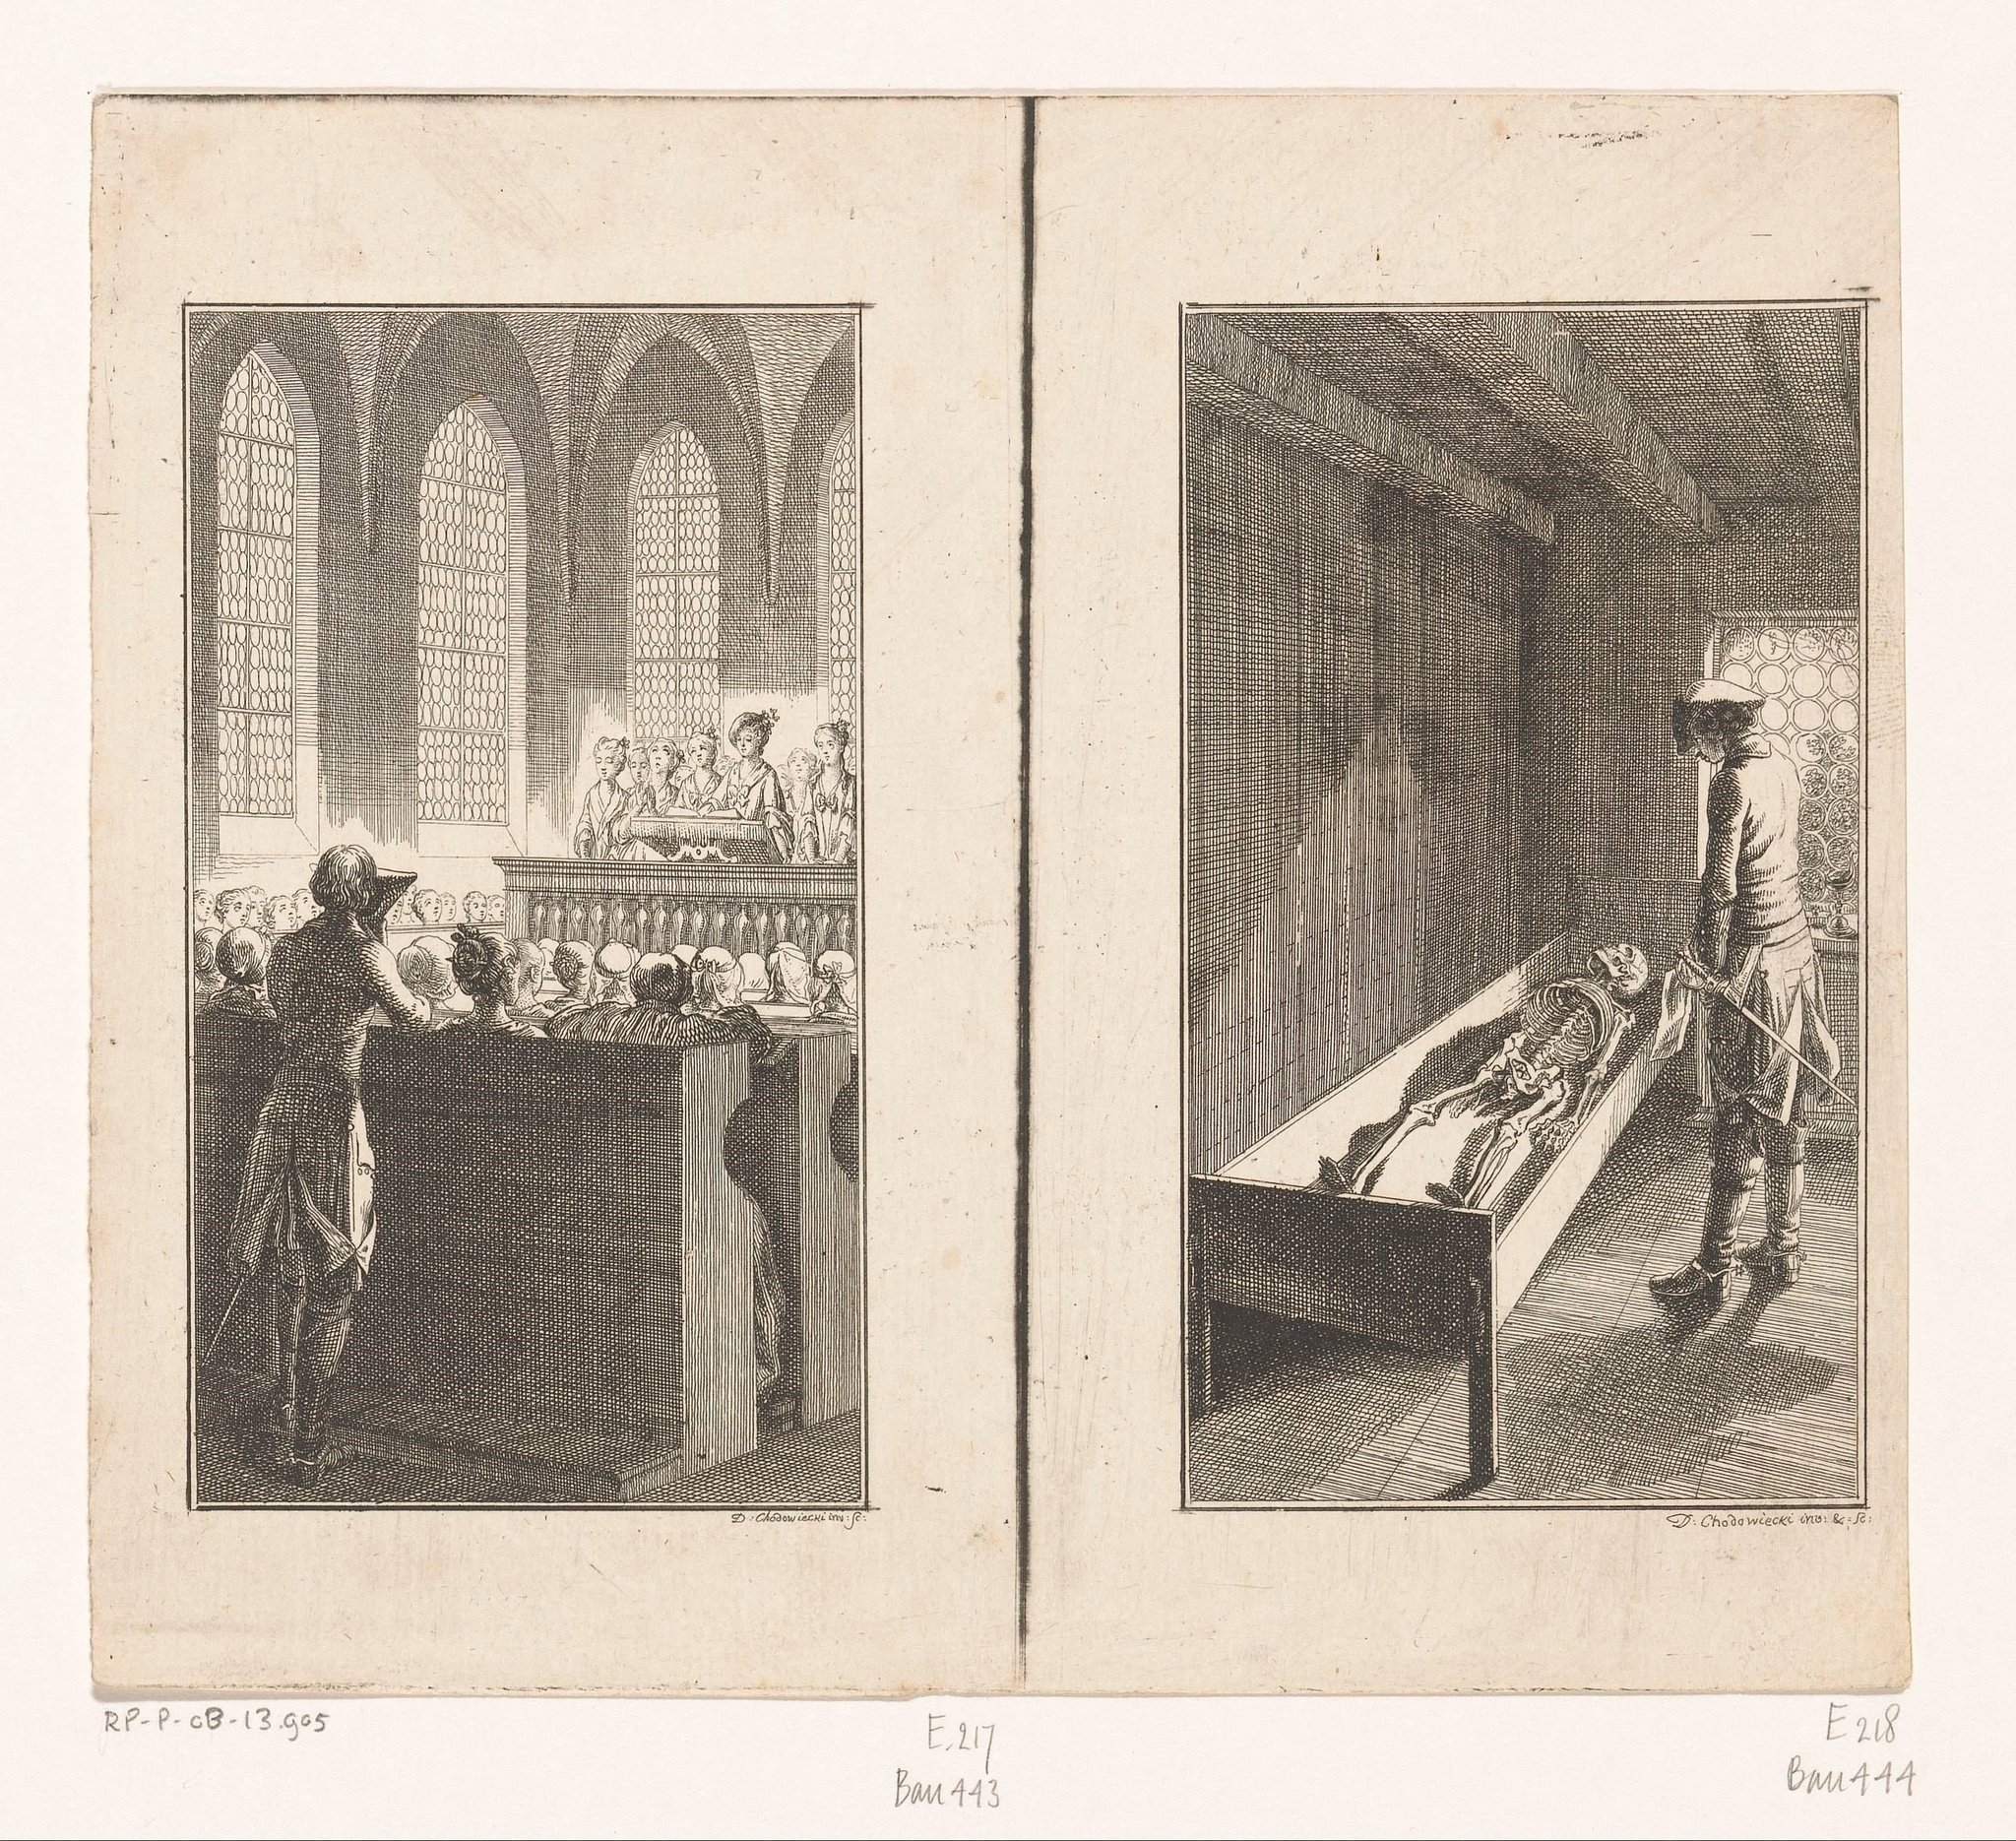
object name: print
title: Twee scènes uit Leben, Bemerkungen und Meinungen Johann Bunkels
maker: daniel nikolaus chodowiecki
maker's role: draughtsman, print maker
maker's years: 1726-1801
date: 1778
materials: paper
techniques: etching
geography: berlin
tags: the congregation, literature, (human) skeleton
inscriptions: collector's mark: Lugt 2228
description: Een latere staat van deze prenten is ook gebruikt in: Leben, Bemerkungen und Meinungen Johann Bunkels, nebst den Leben verscheidener merkwürdiger Frauenzimmer. 4 dln. Berlijn: Friedrich Nicolai, 1778. De Engelse uitgave verscheen tussen 1756-1766 onder de titel 'The life of John Buncle' en wordt meestal toegeschreven aan Thomas Armory. Chodowiecki etste in totaal 16 scènes voor dit werk.